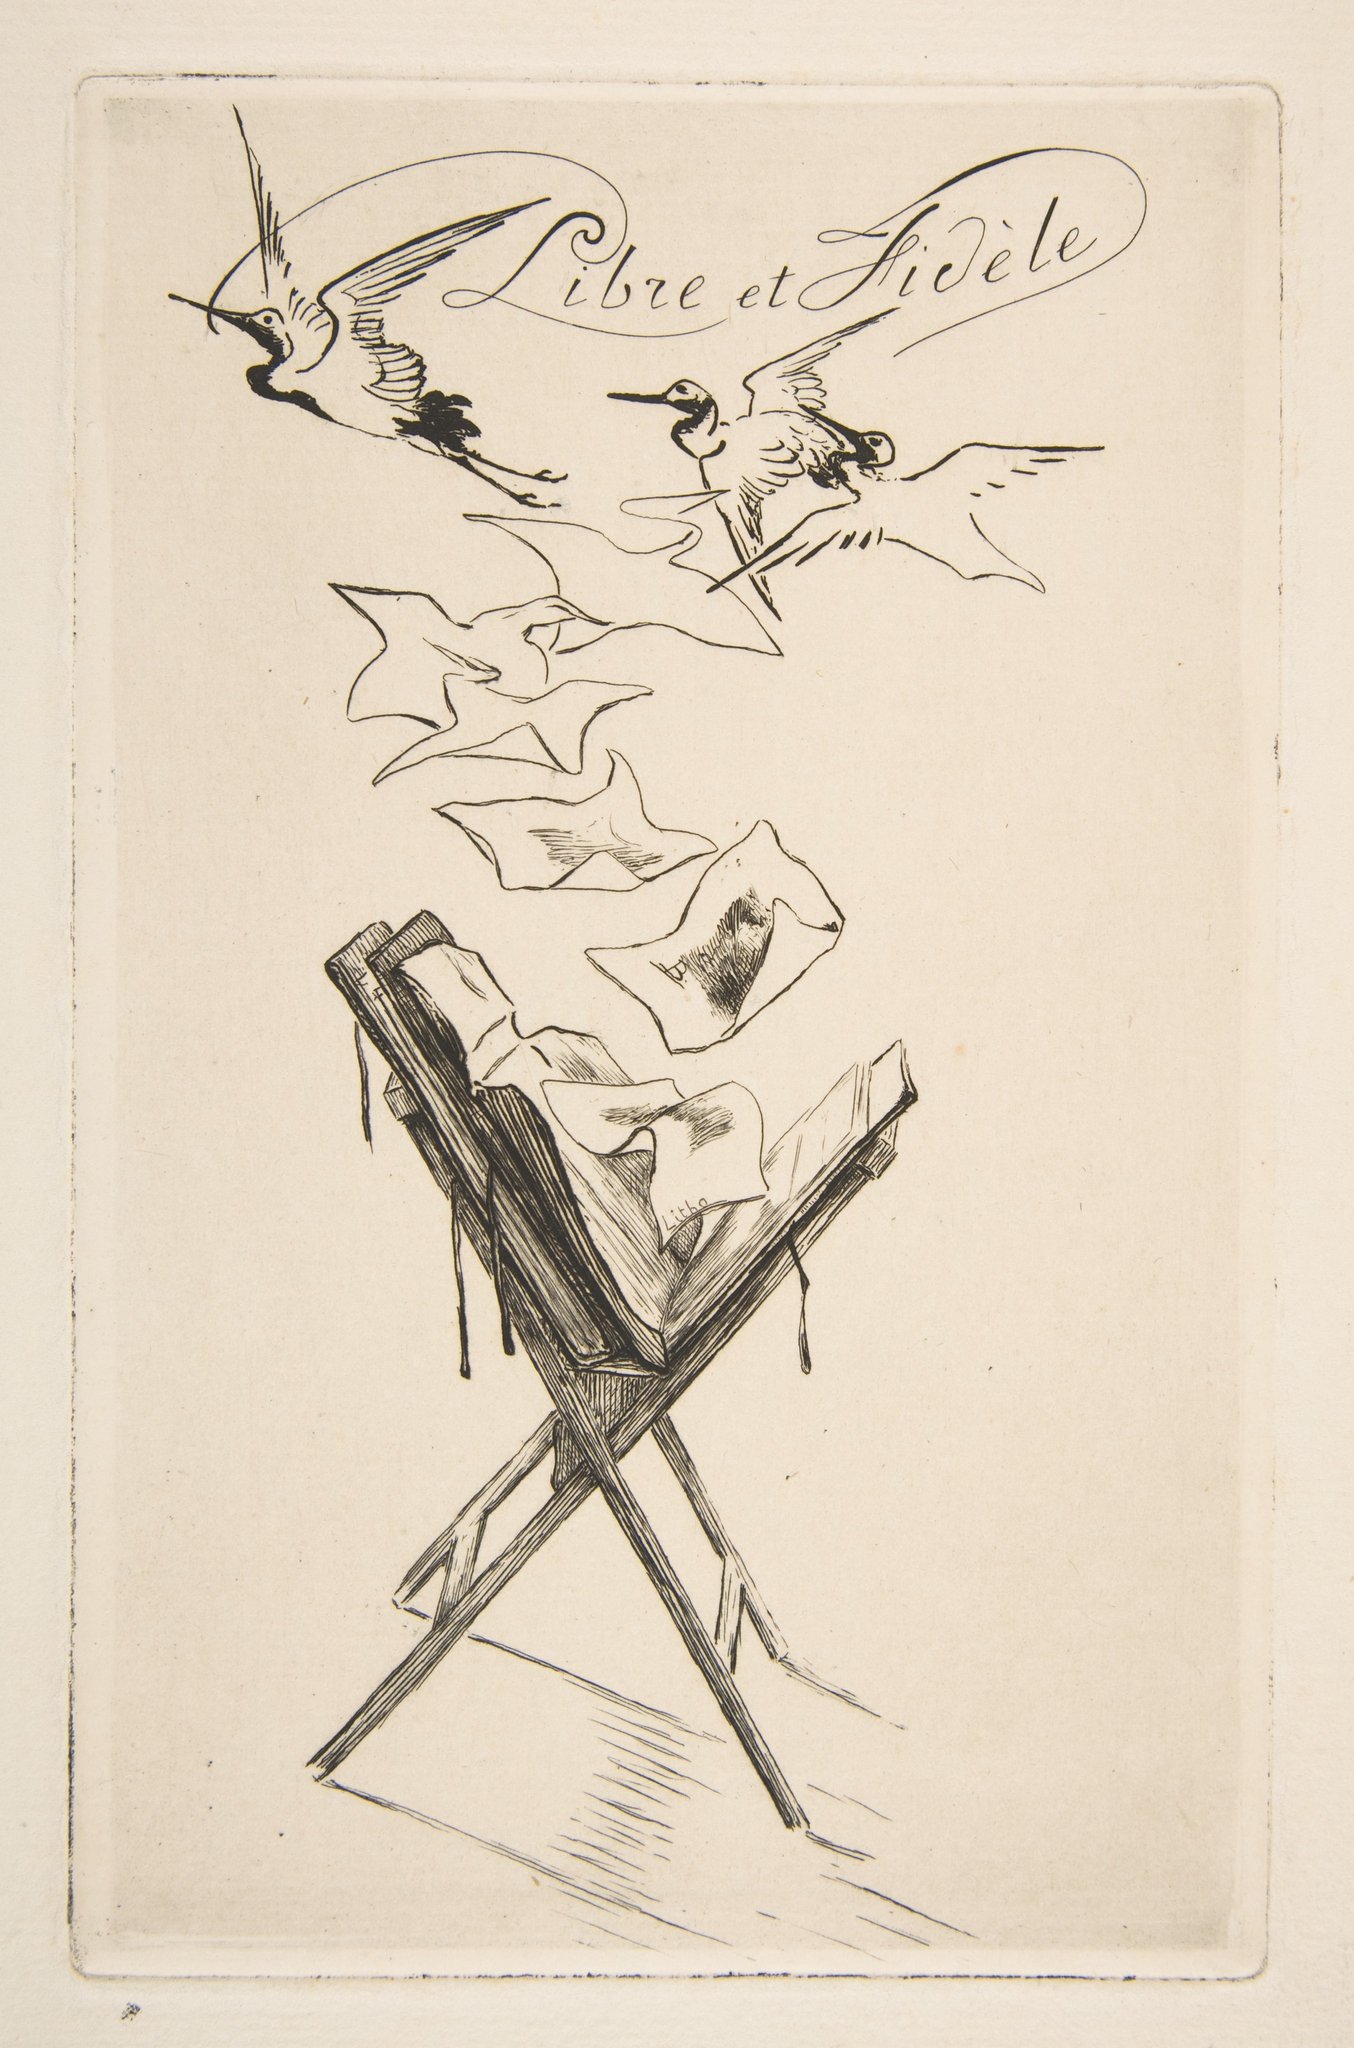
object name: print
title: Libre et Fidèle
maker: félix bracquemond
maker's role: artist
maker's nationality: french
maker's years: 1833-1914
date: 1878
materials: paper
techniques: etching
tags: birds